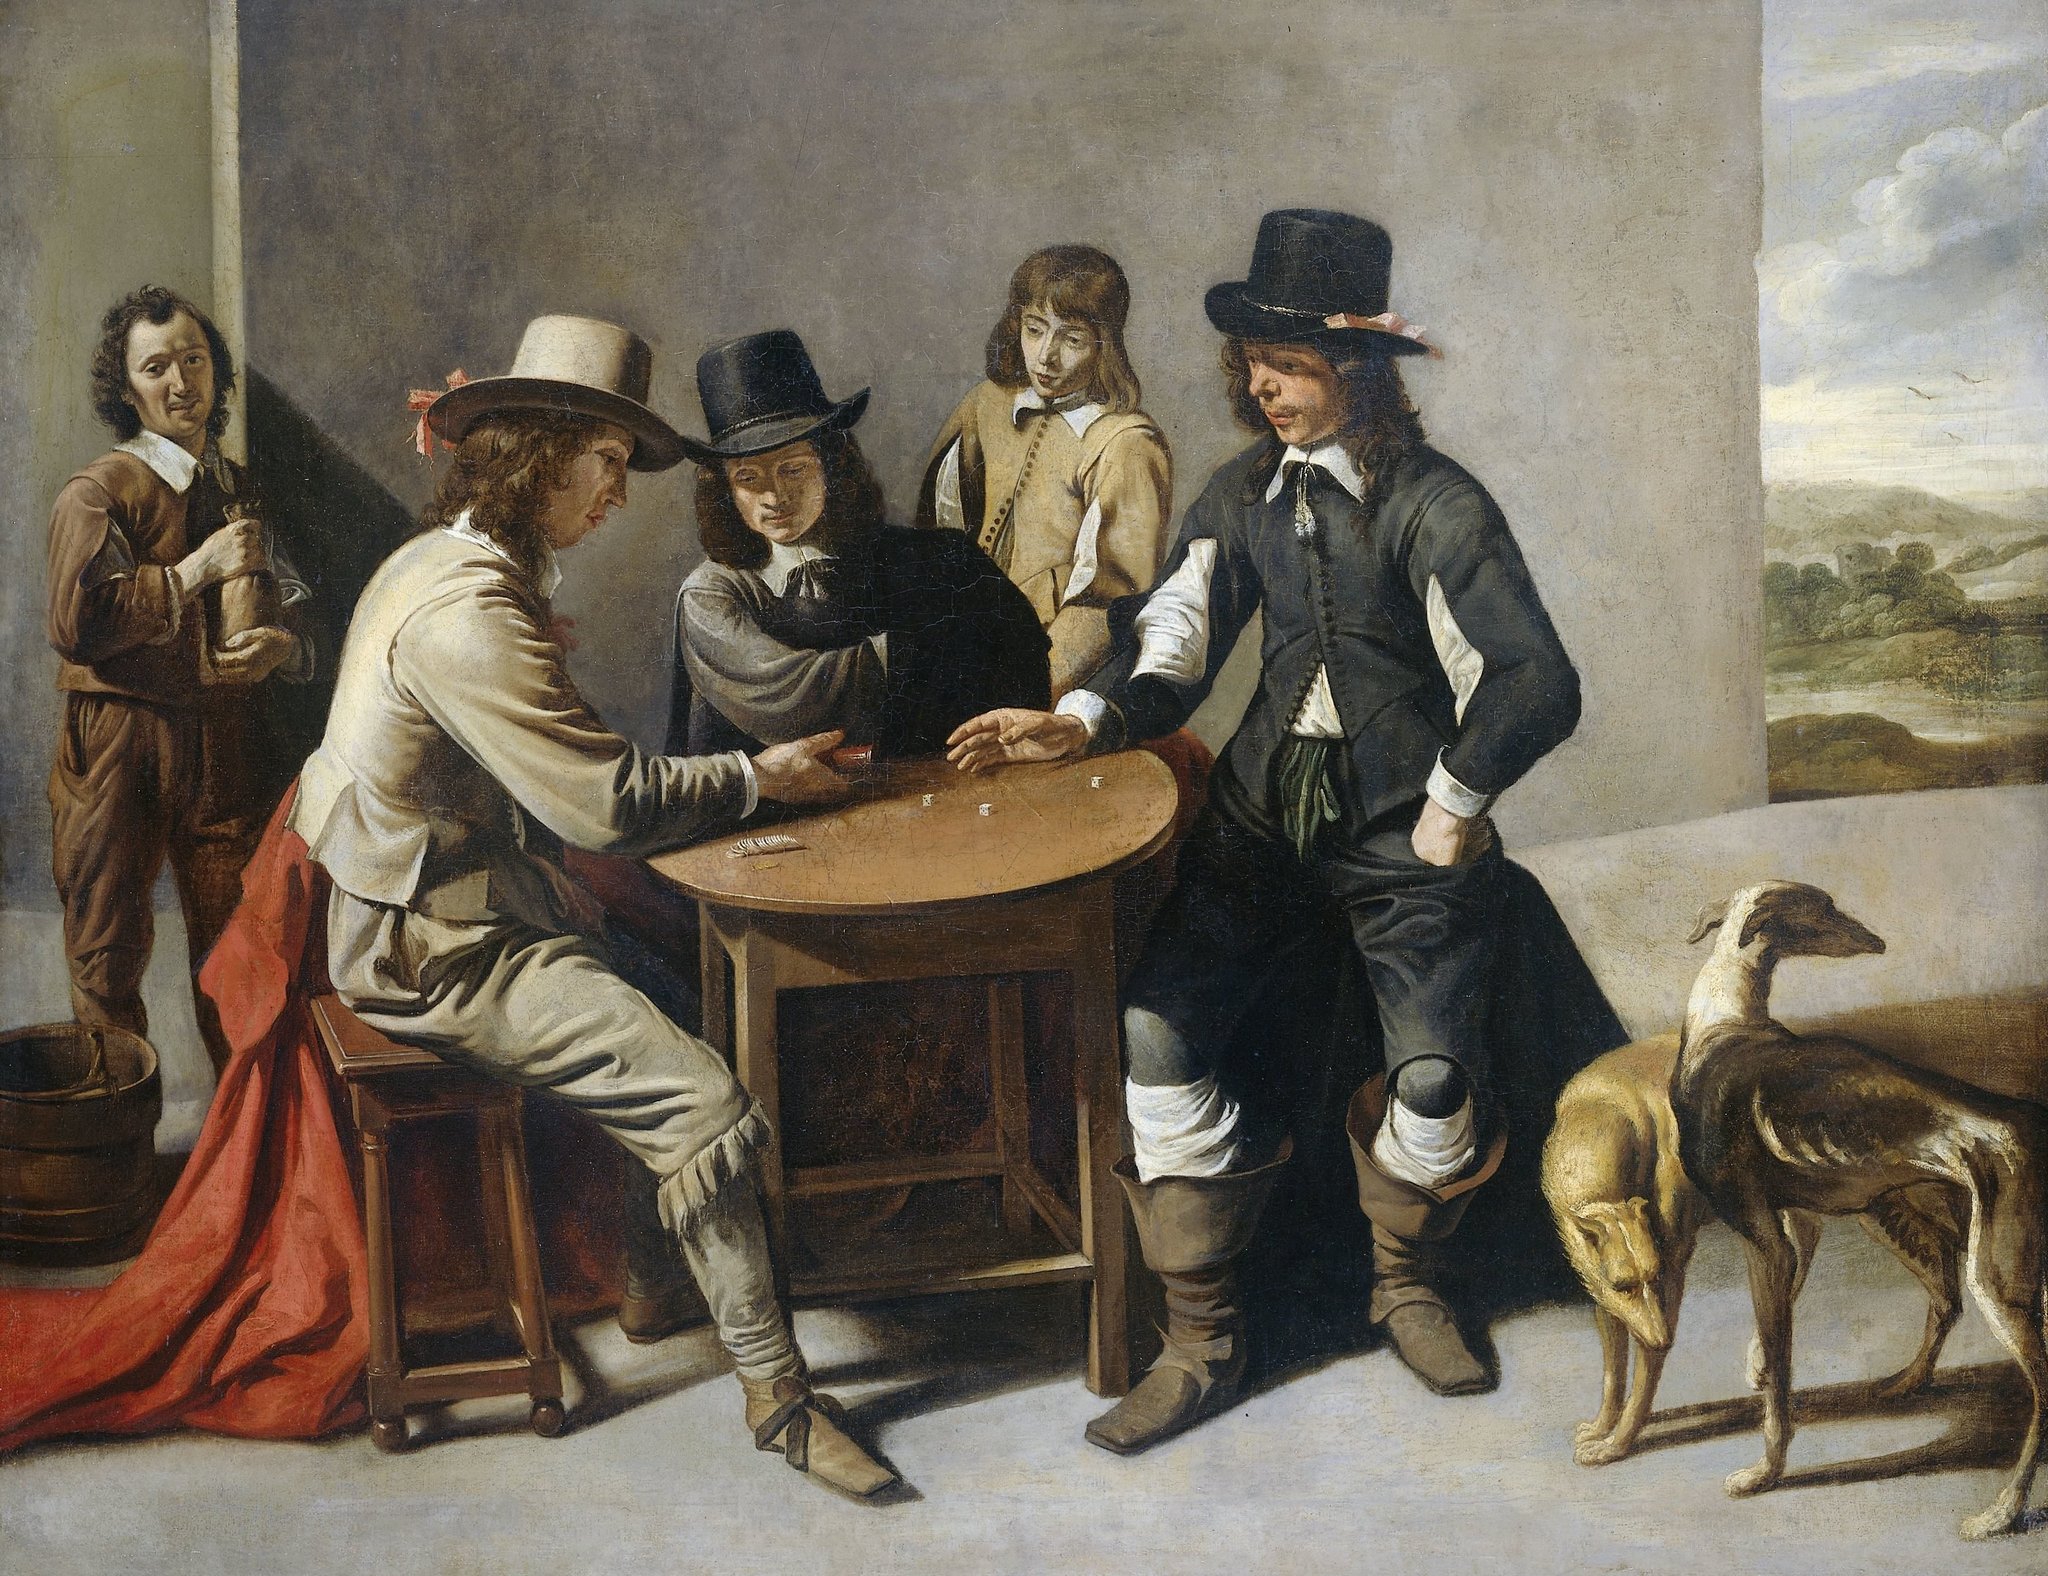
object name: painting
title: The Dice Shooters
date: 1630-1680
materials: canvas, oil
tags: dice-games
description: De dobbelaars. Drie dobbelende mannen gezeten rond een tafel, twee andere mannen kijken toe. Rechts twee honden. Een schets van een dergelijke compositie door Gabriel de Saint-Aubin in de collectie van de Bibliothèque Nationale te Parijs.